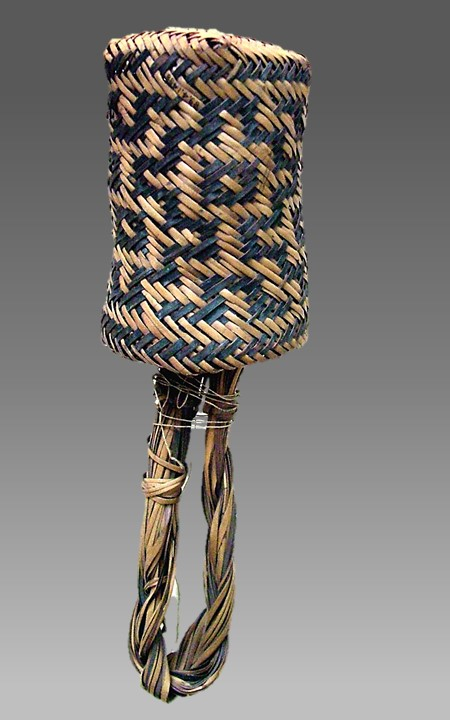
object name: shak shak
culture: native american or guyanese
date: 1801-1900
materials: cord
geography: guyana